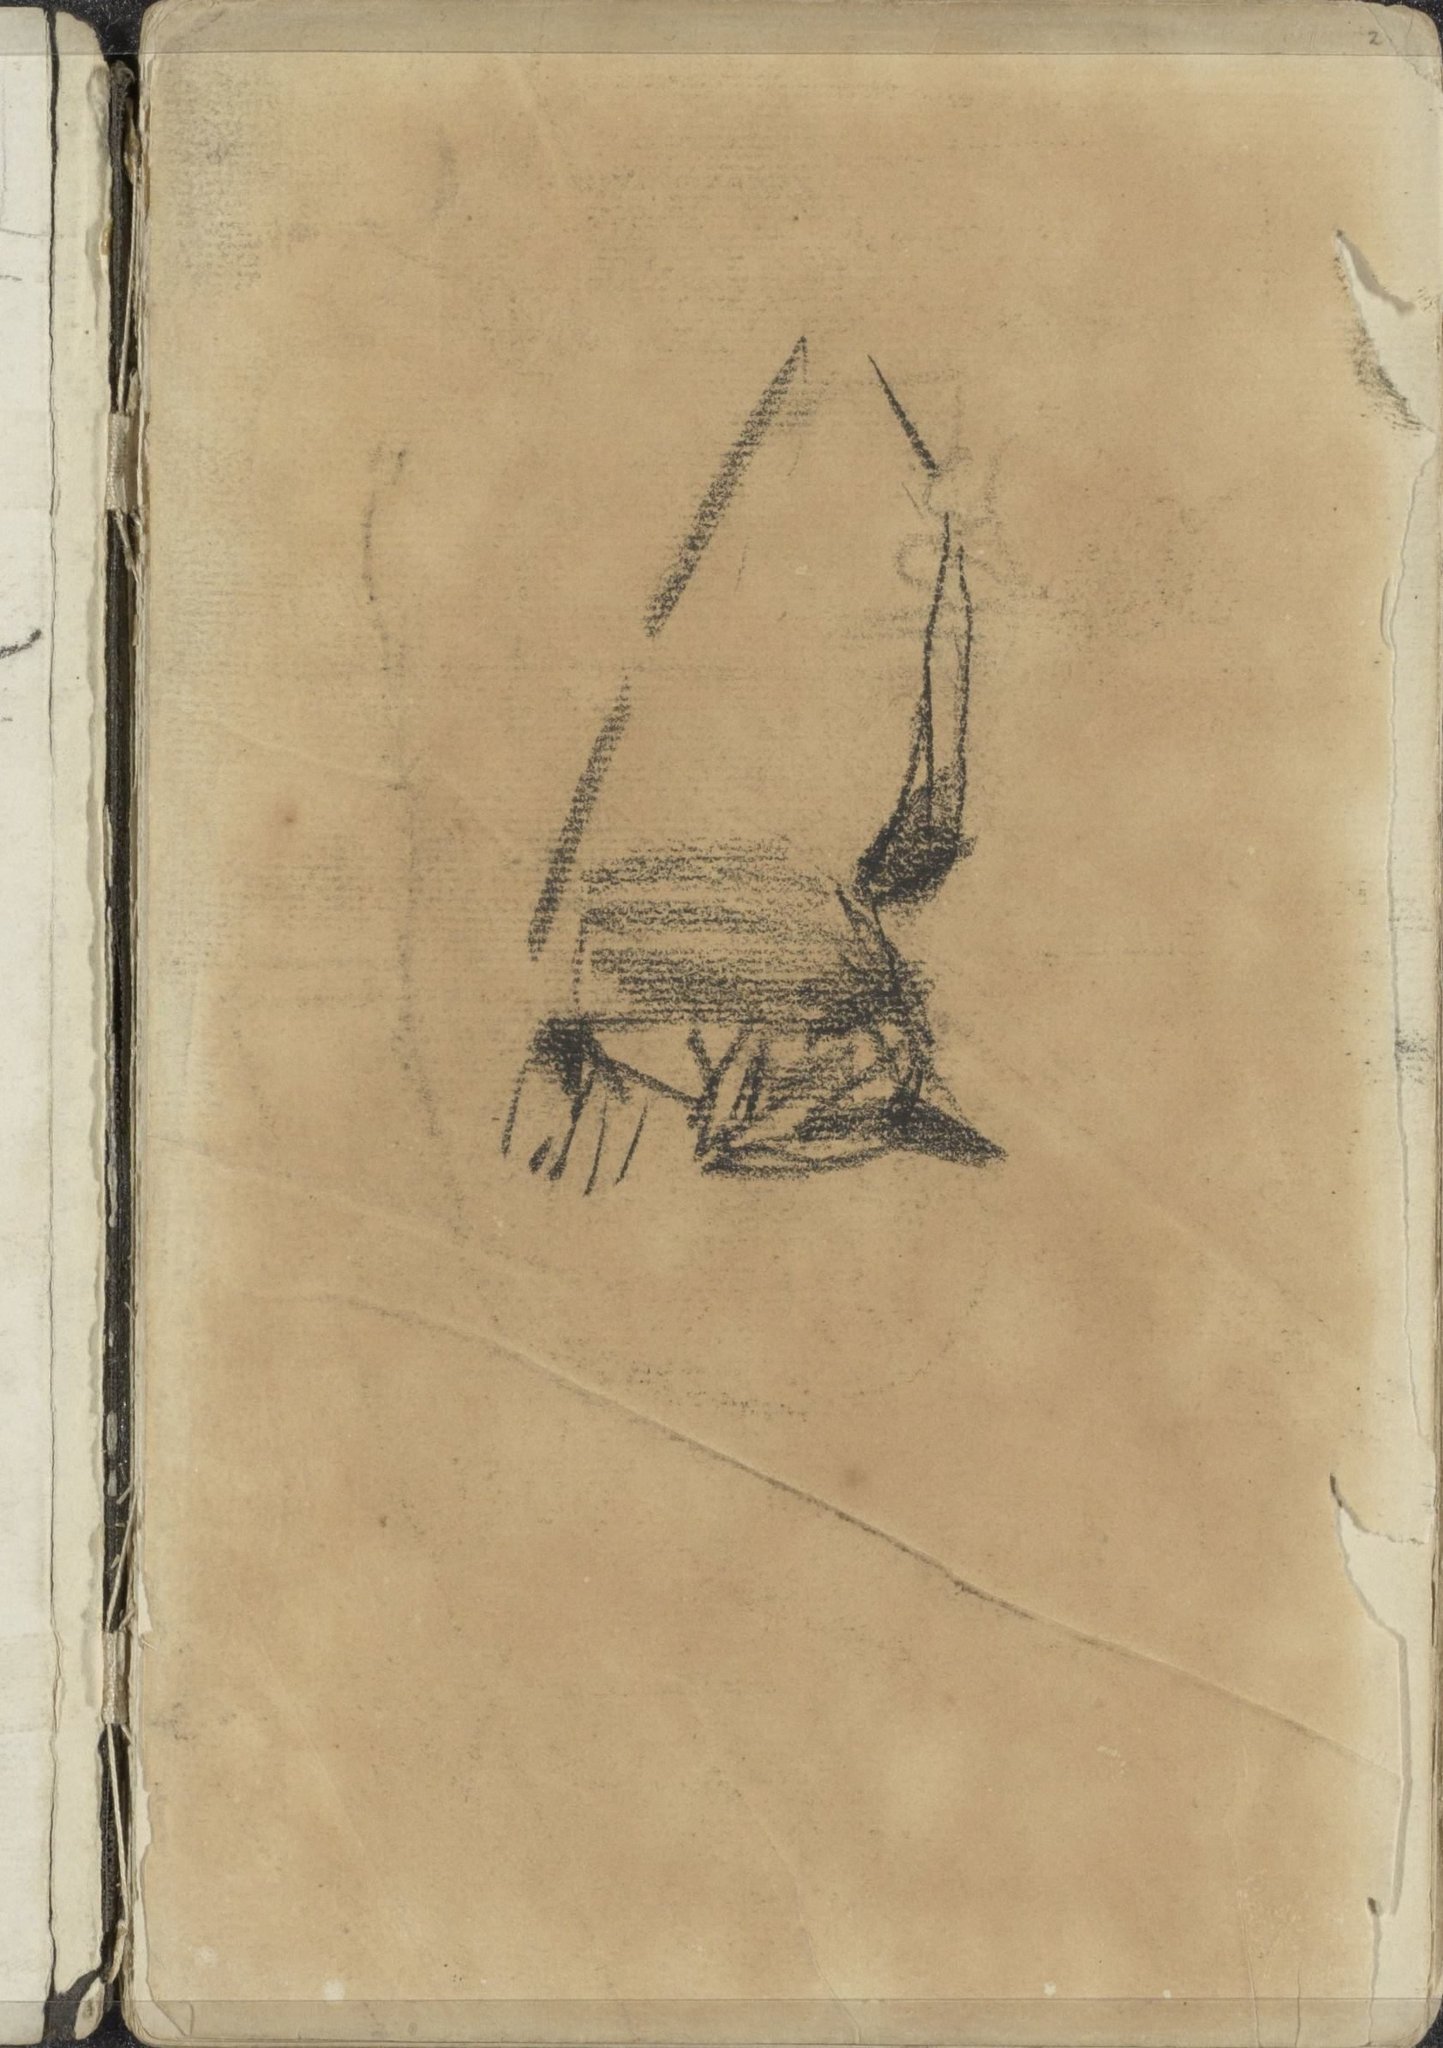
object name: sketchbook leaf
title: Liggende kat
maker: george hendrik breitner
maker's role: draughtsman, painter, print maker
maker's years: 1857-1923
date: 1886-1923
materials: chalk, paper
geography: amsterdam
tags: cat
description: Pagina 2 uit een schetsboek met 13 bladen.